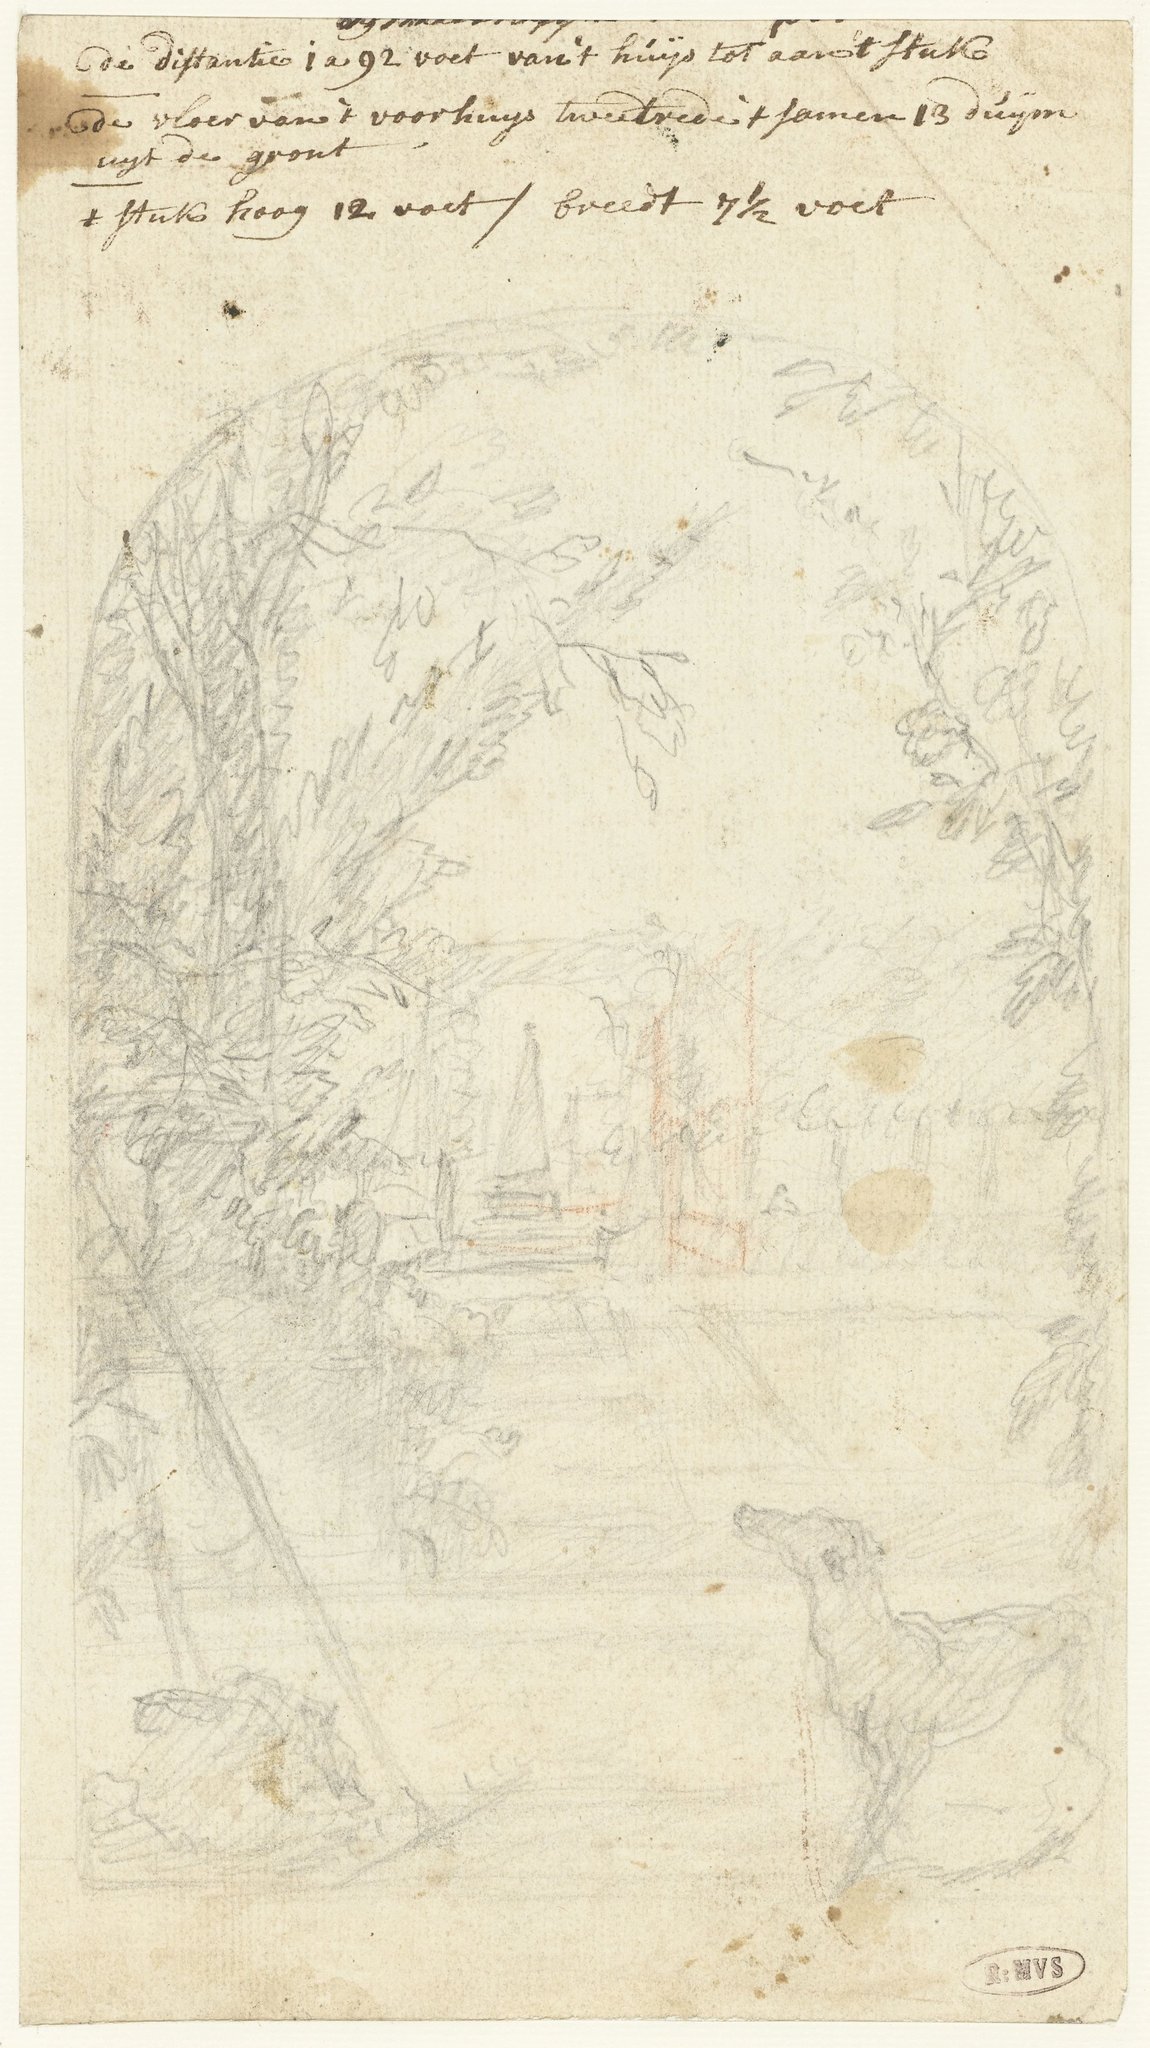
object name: design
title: Ontwerp voor een tuingezicht met een hond en tuingereedschap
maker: dionys van nijmegen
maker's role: draughtsman, painter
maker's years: 1705-1798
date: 1715-1798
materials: chalk, paper, pencil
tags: garden